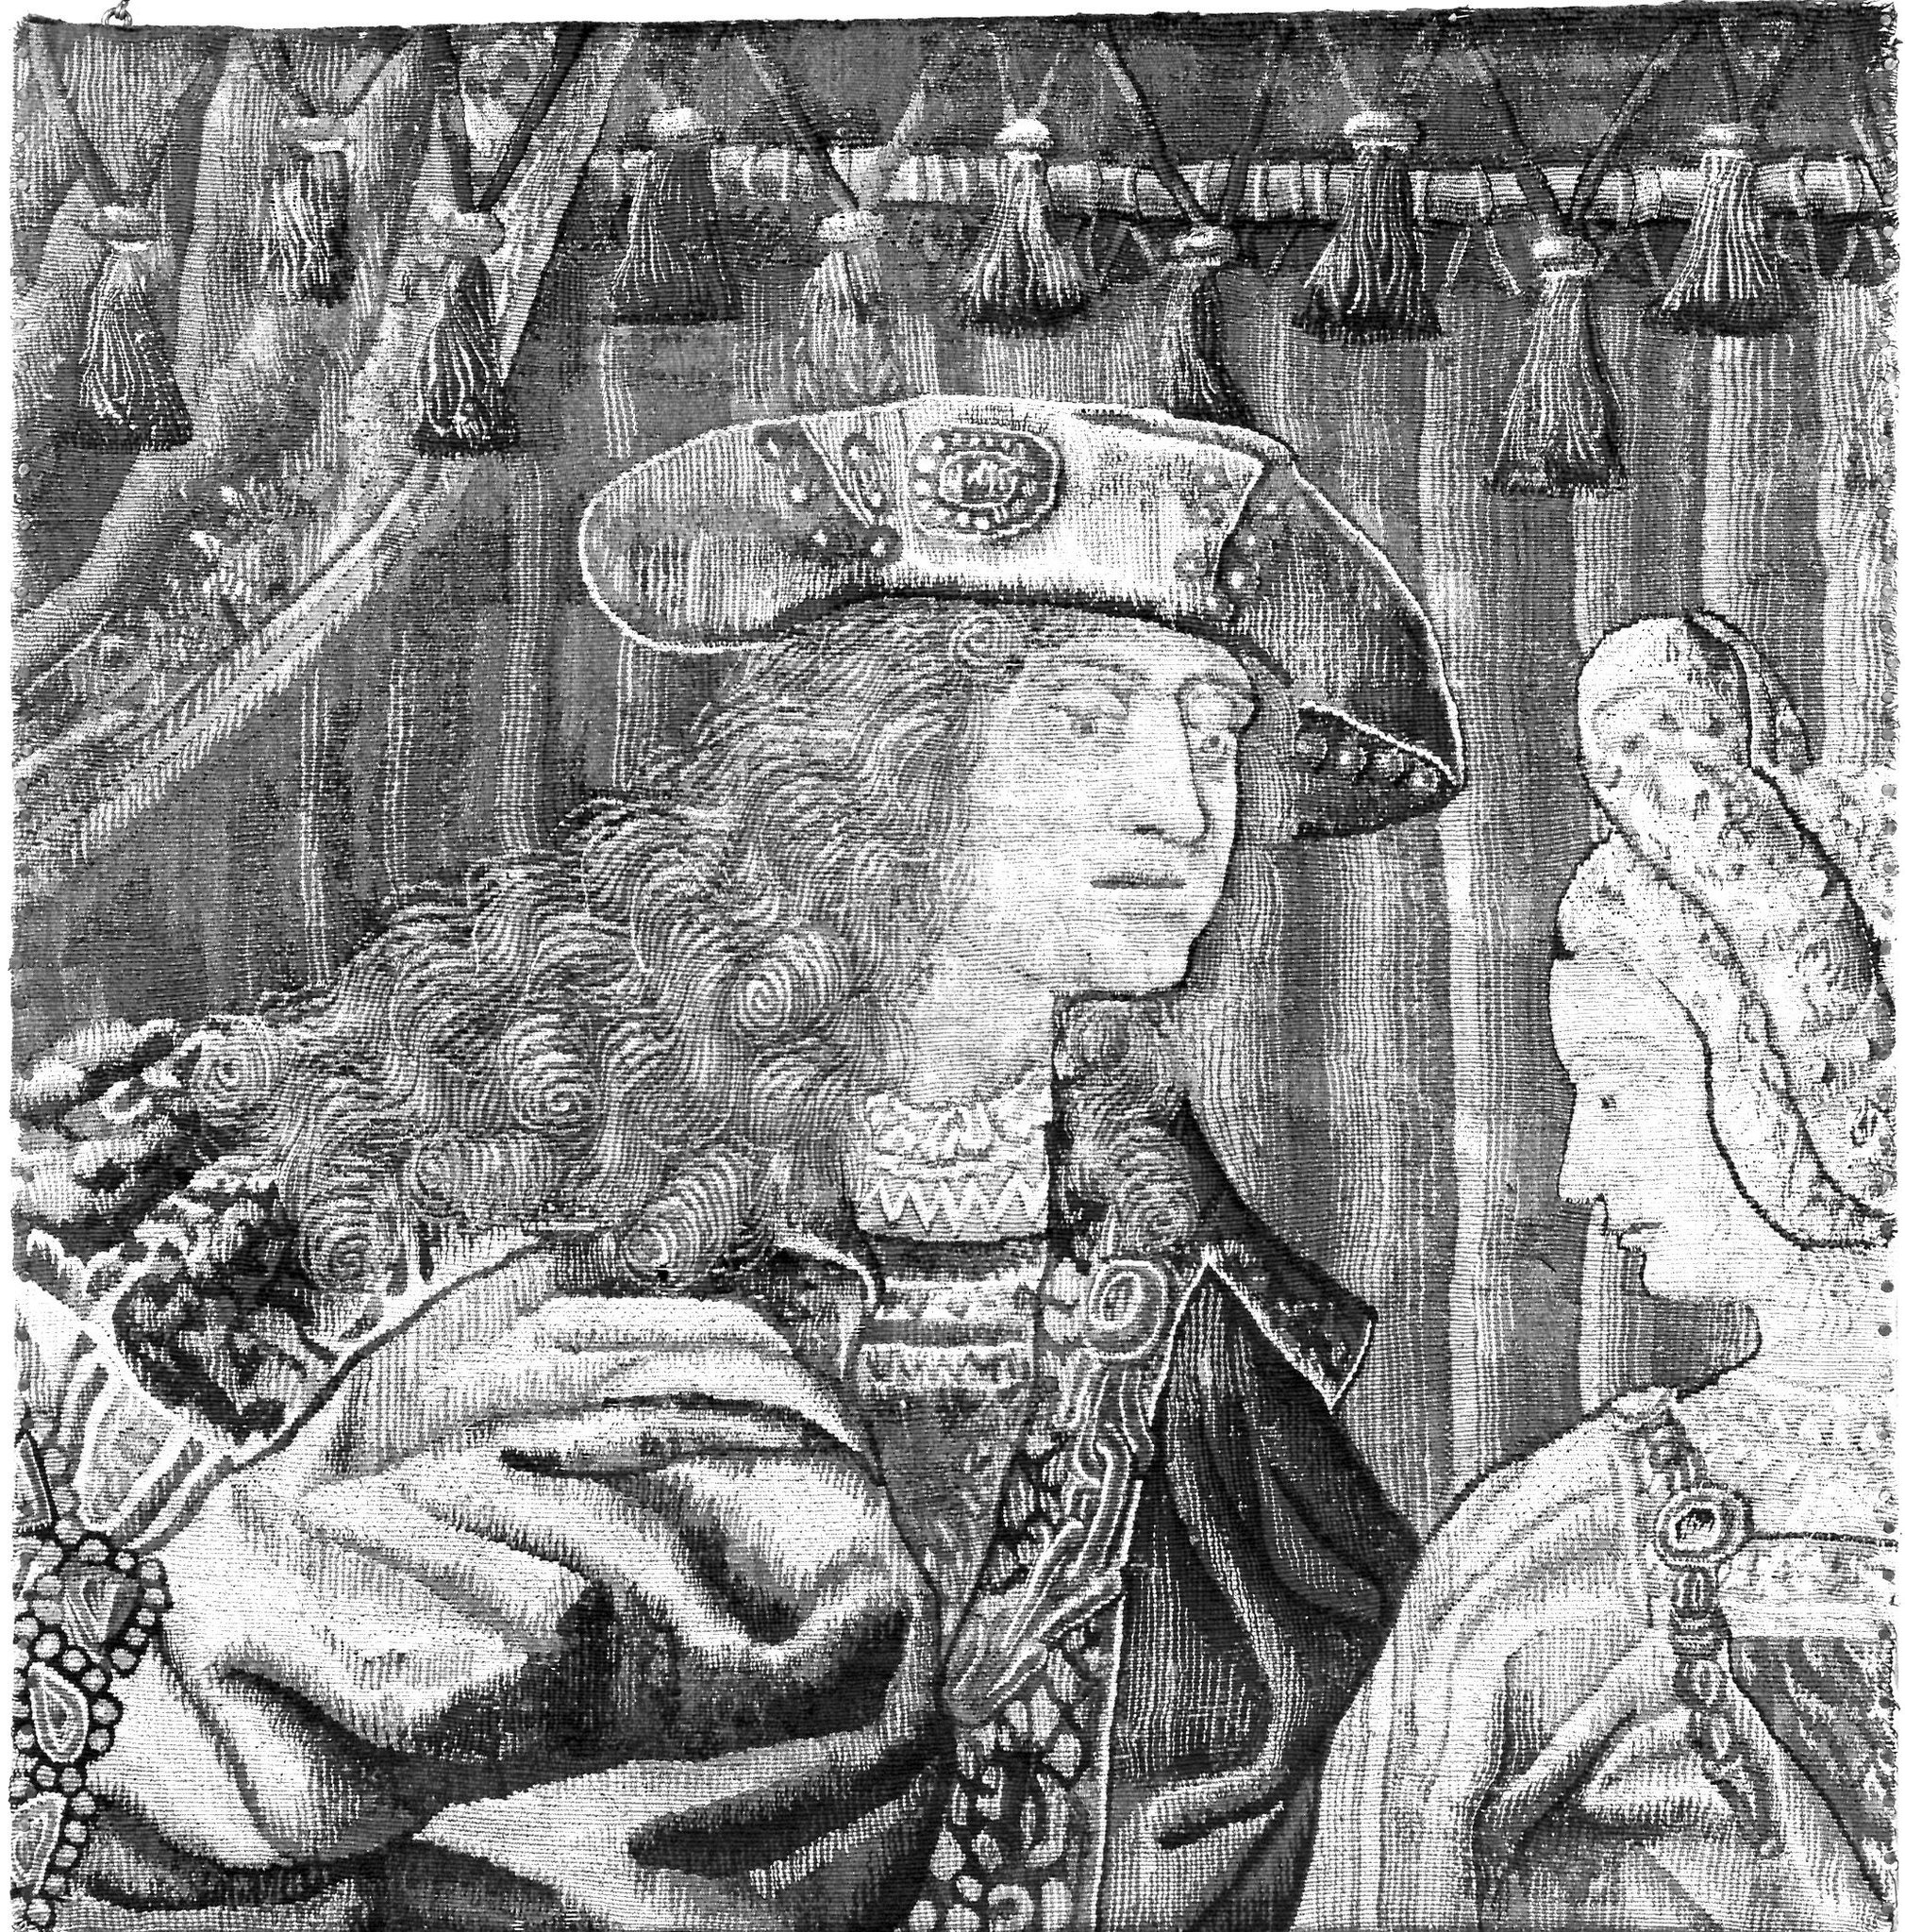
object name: tapestry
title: Lady and Gentleman in front of Two Curtains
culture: south netherlandish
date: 1510-1525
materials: silk, wool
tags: men,women